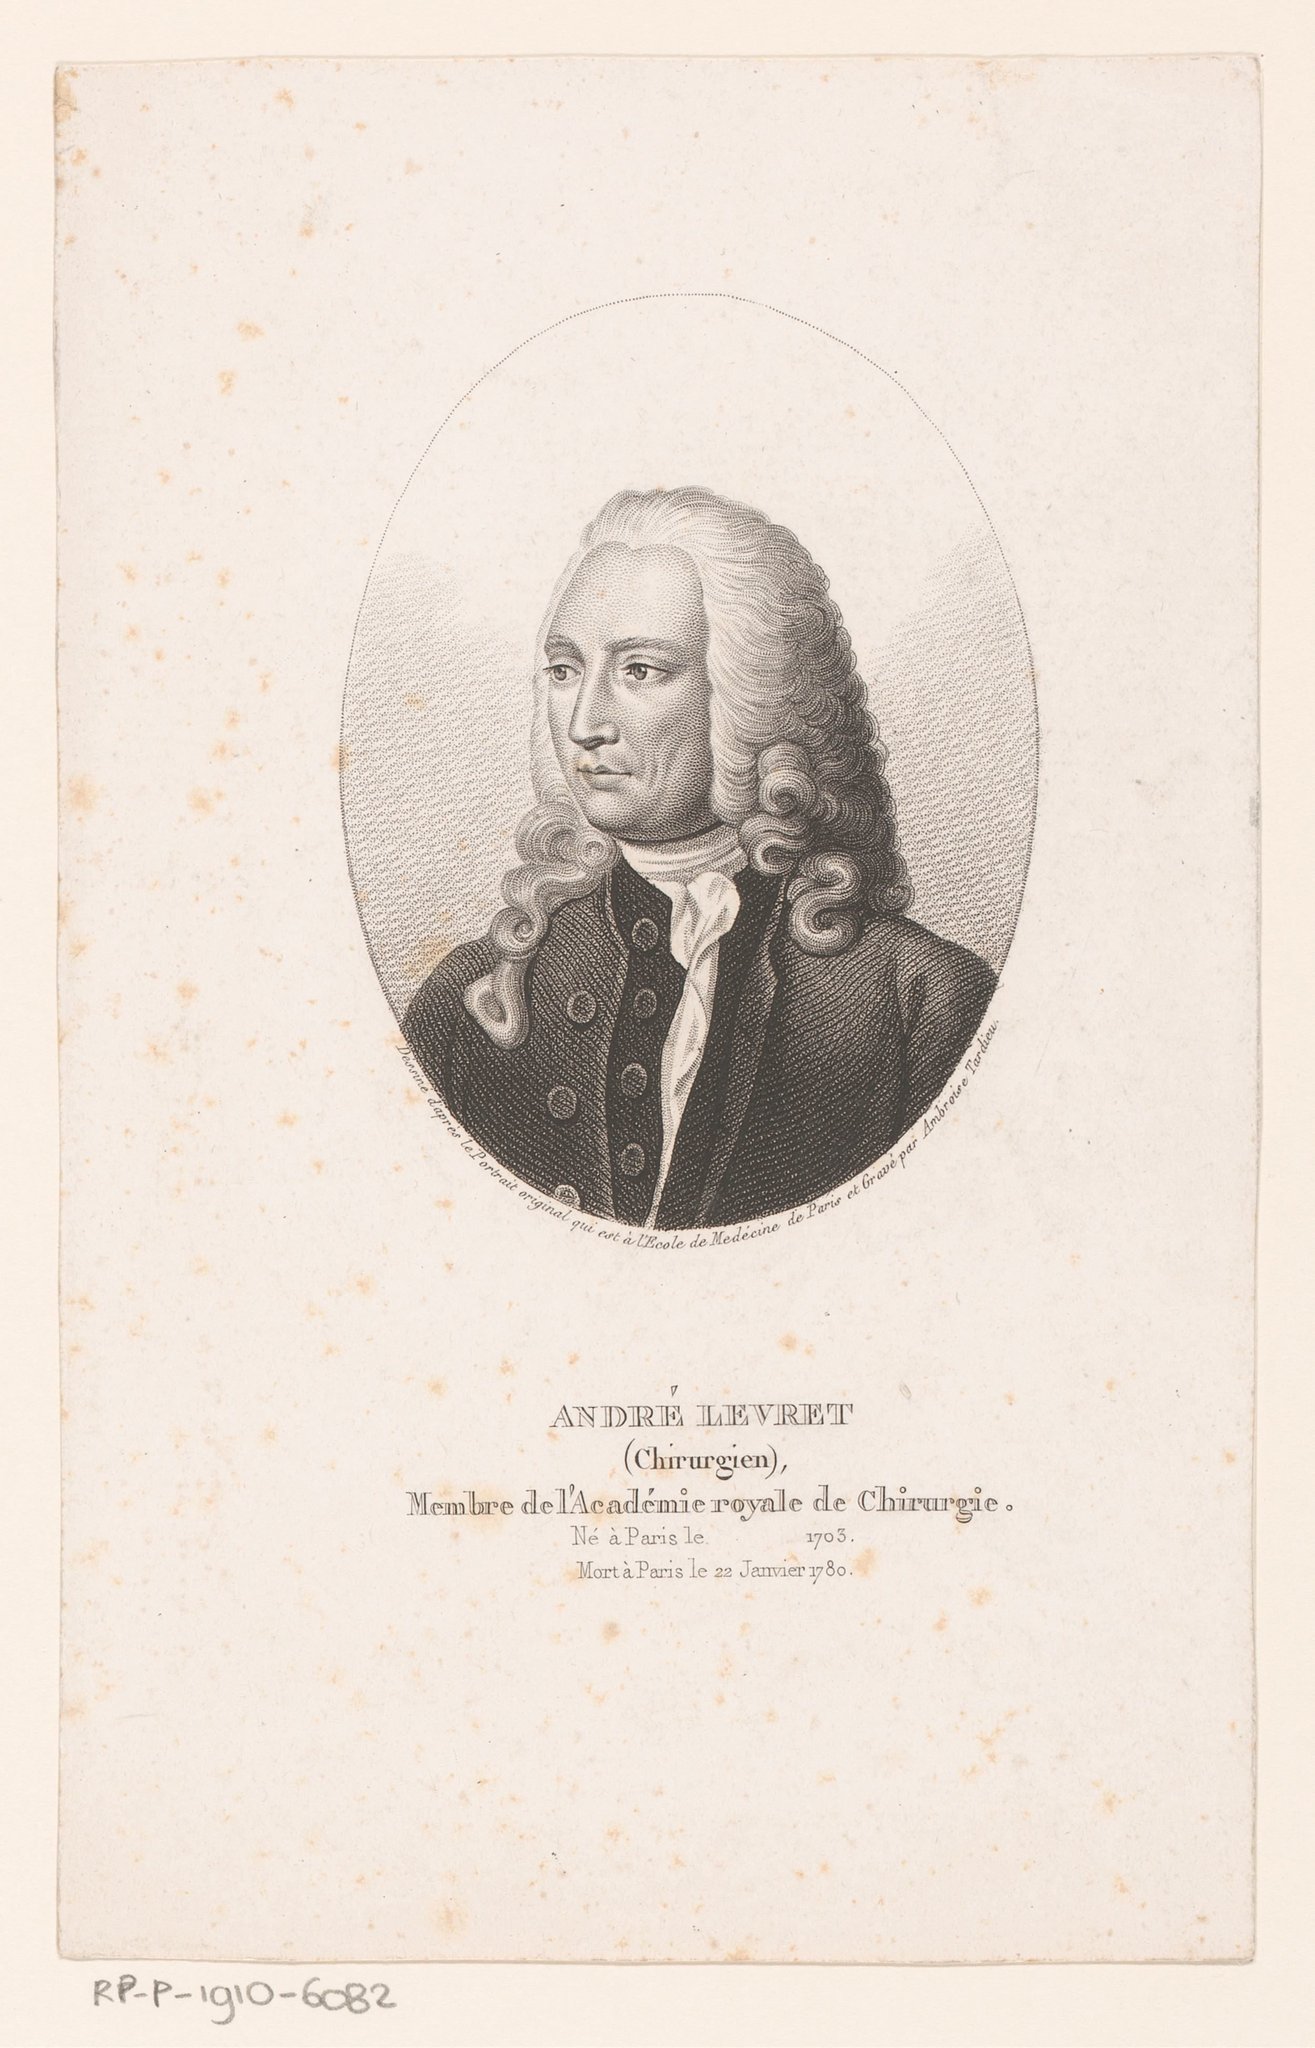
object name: print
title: Compleet overzicht van beroemdheden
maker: ambroise tardieu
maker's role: print maker, printer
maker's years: 1788-1841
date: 1820-1828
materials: paper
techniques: engraving, roulette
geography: paris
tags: paris, historical persons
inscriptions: collector's mark: Lugt 2228